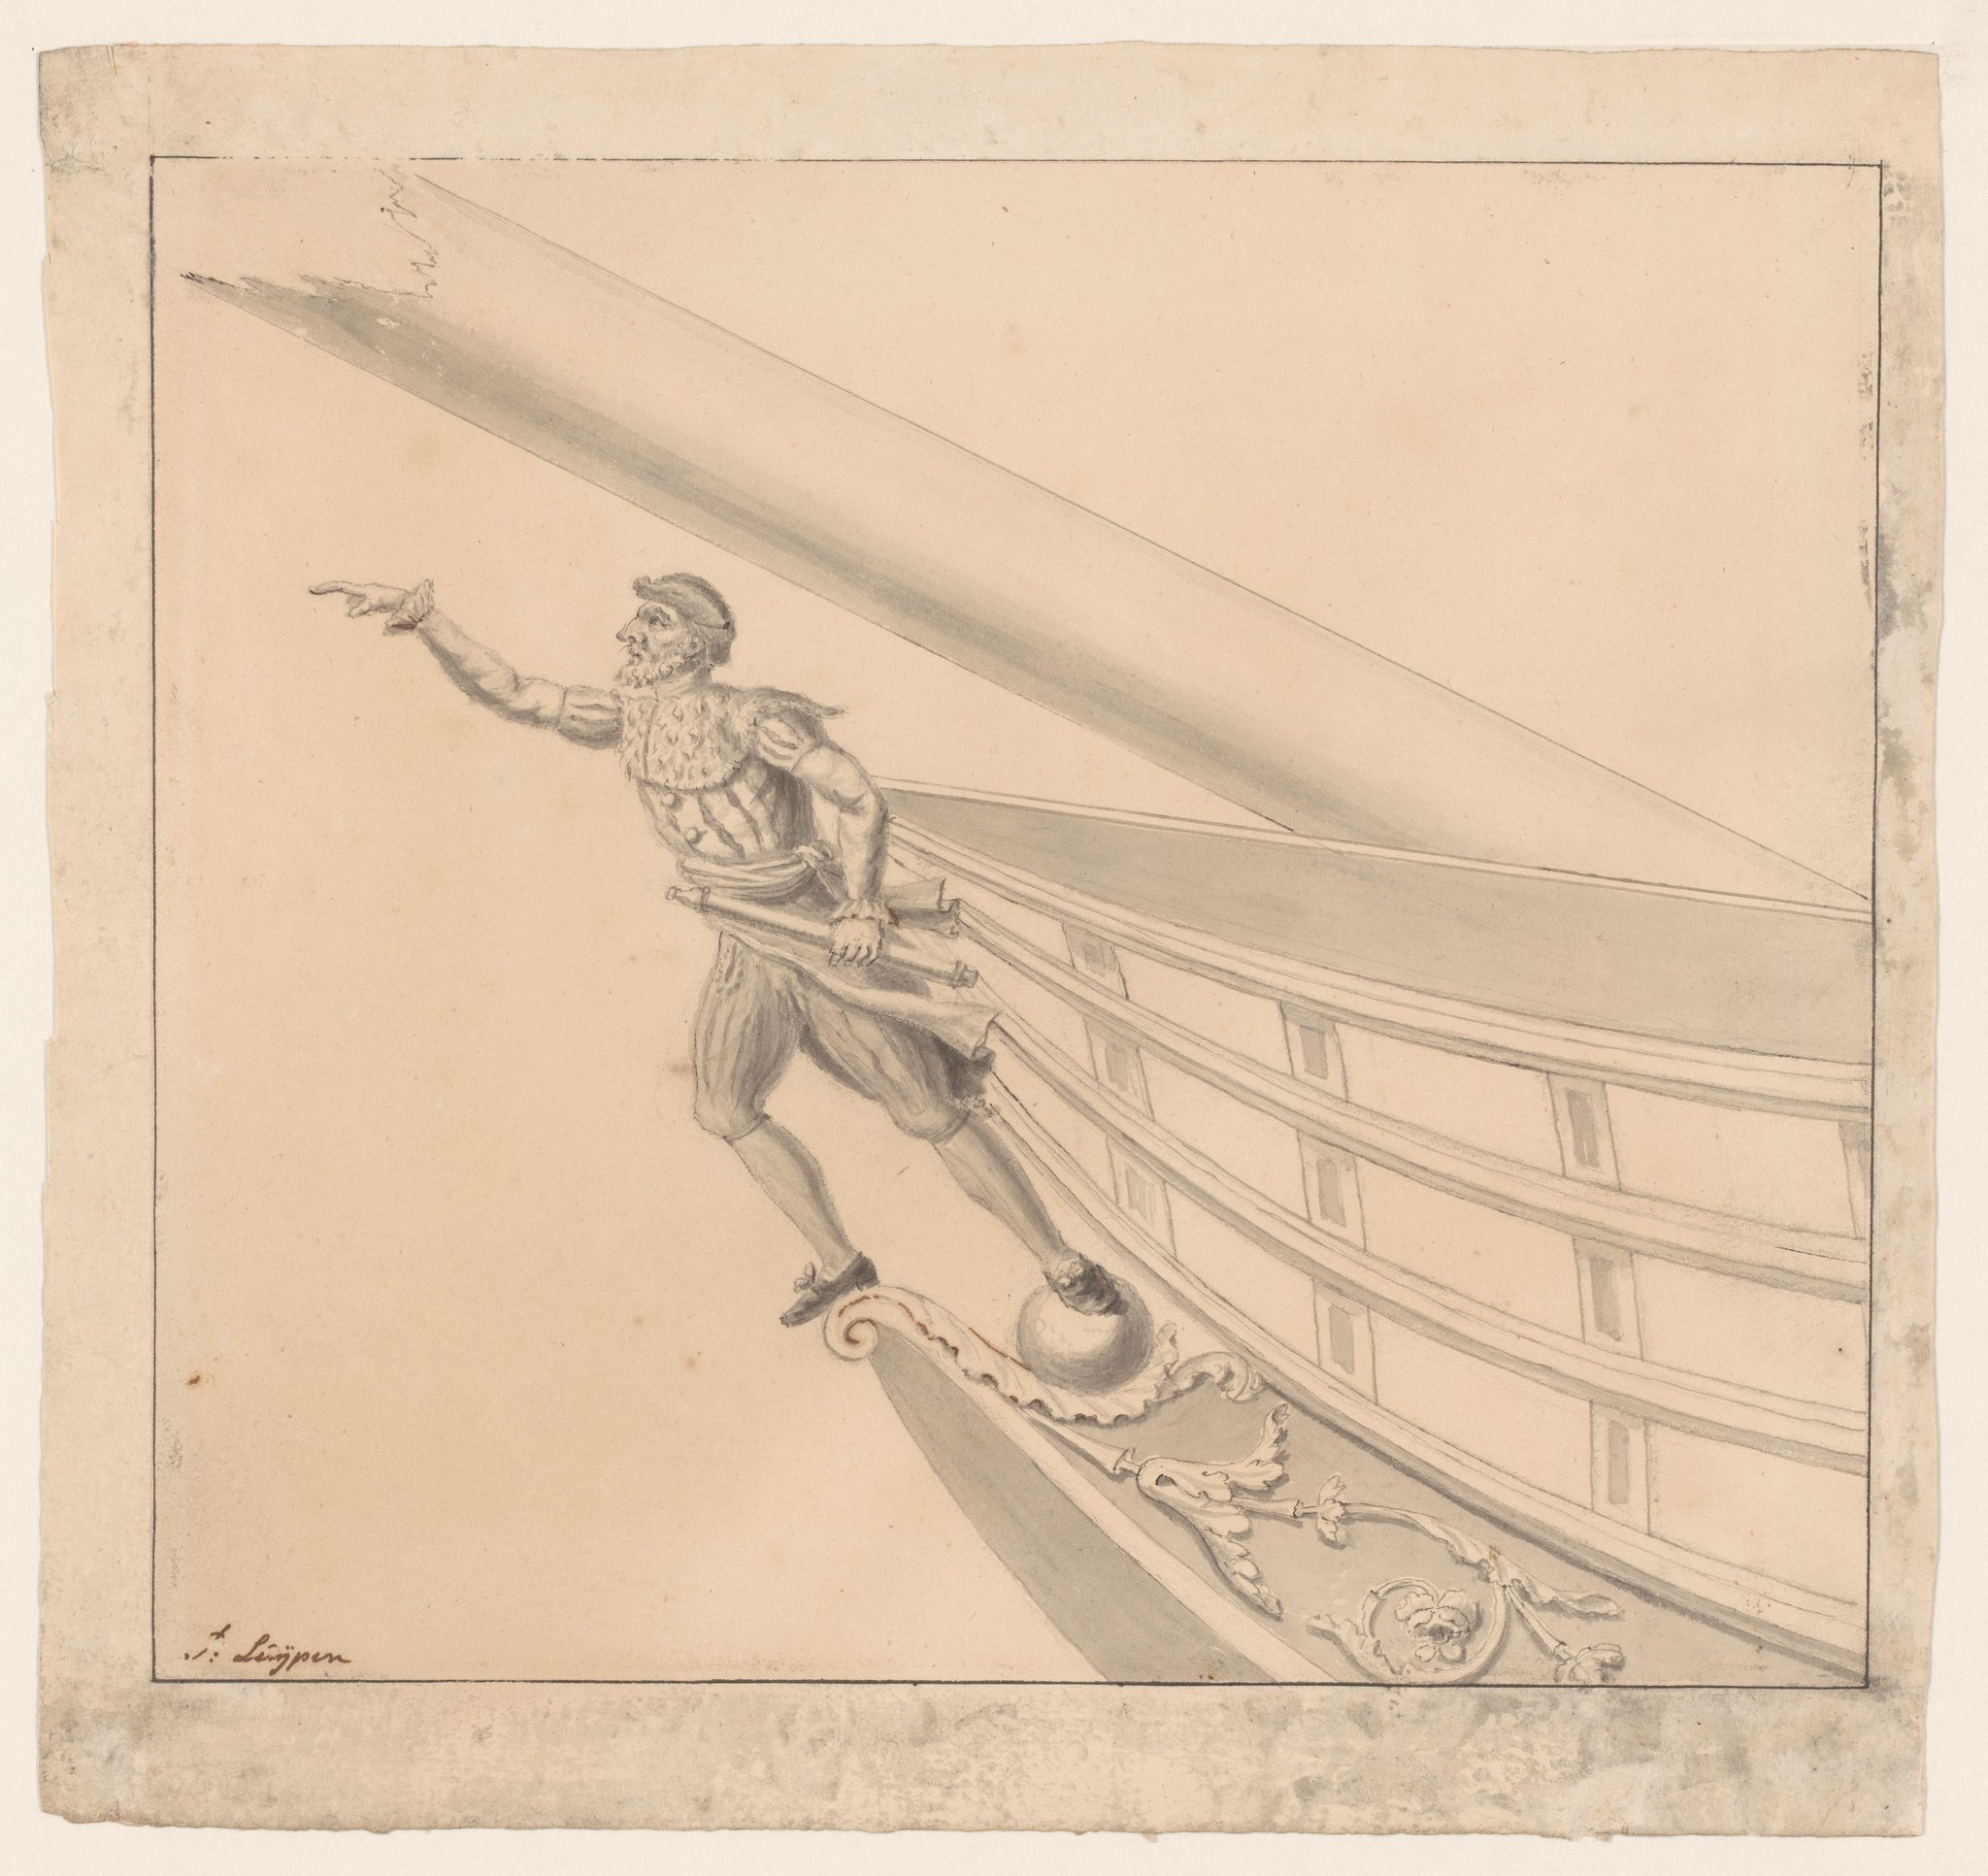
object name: drawing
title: Boegbeeld van een man met een verrekijker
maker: pieter luypen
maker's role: draughtsman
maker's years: 1763-1833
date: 1790-1810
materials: ink, paper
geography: amsterdam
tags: parts of ship's exterior: bow, telescope, parts of ship's exterior: figure-head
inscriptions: signature: ‘P: Luijpen’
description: Boegbeeld, man wiens linkervoet op bol staat, in linkerhand een verrekijker houdend en met de rechter naar voren wijzend, met baard en hoedje, sjerp om het middel, met halflange broek aann en met pofmouwen. Daaronder deel van de boeg, versierd, rechts deel van de bespanning en daarboven deel van de spriet.